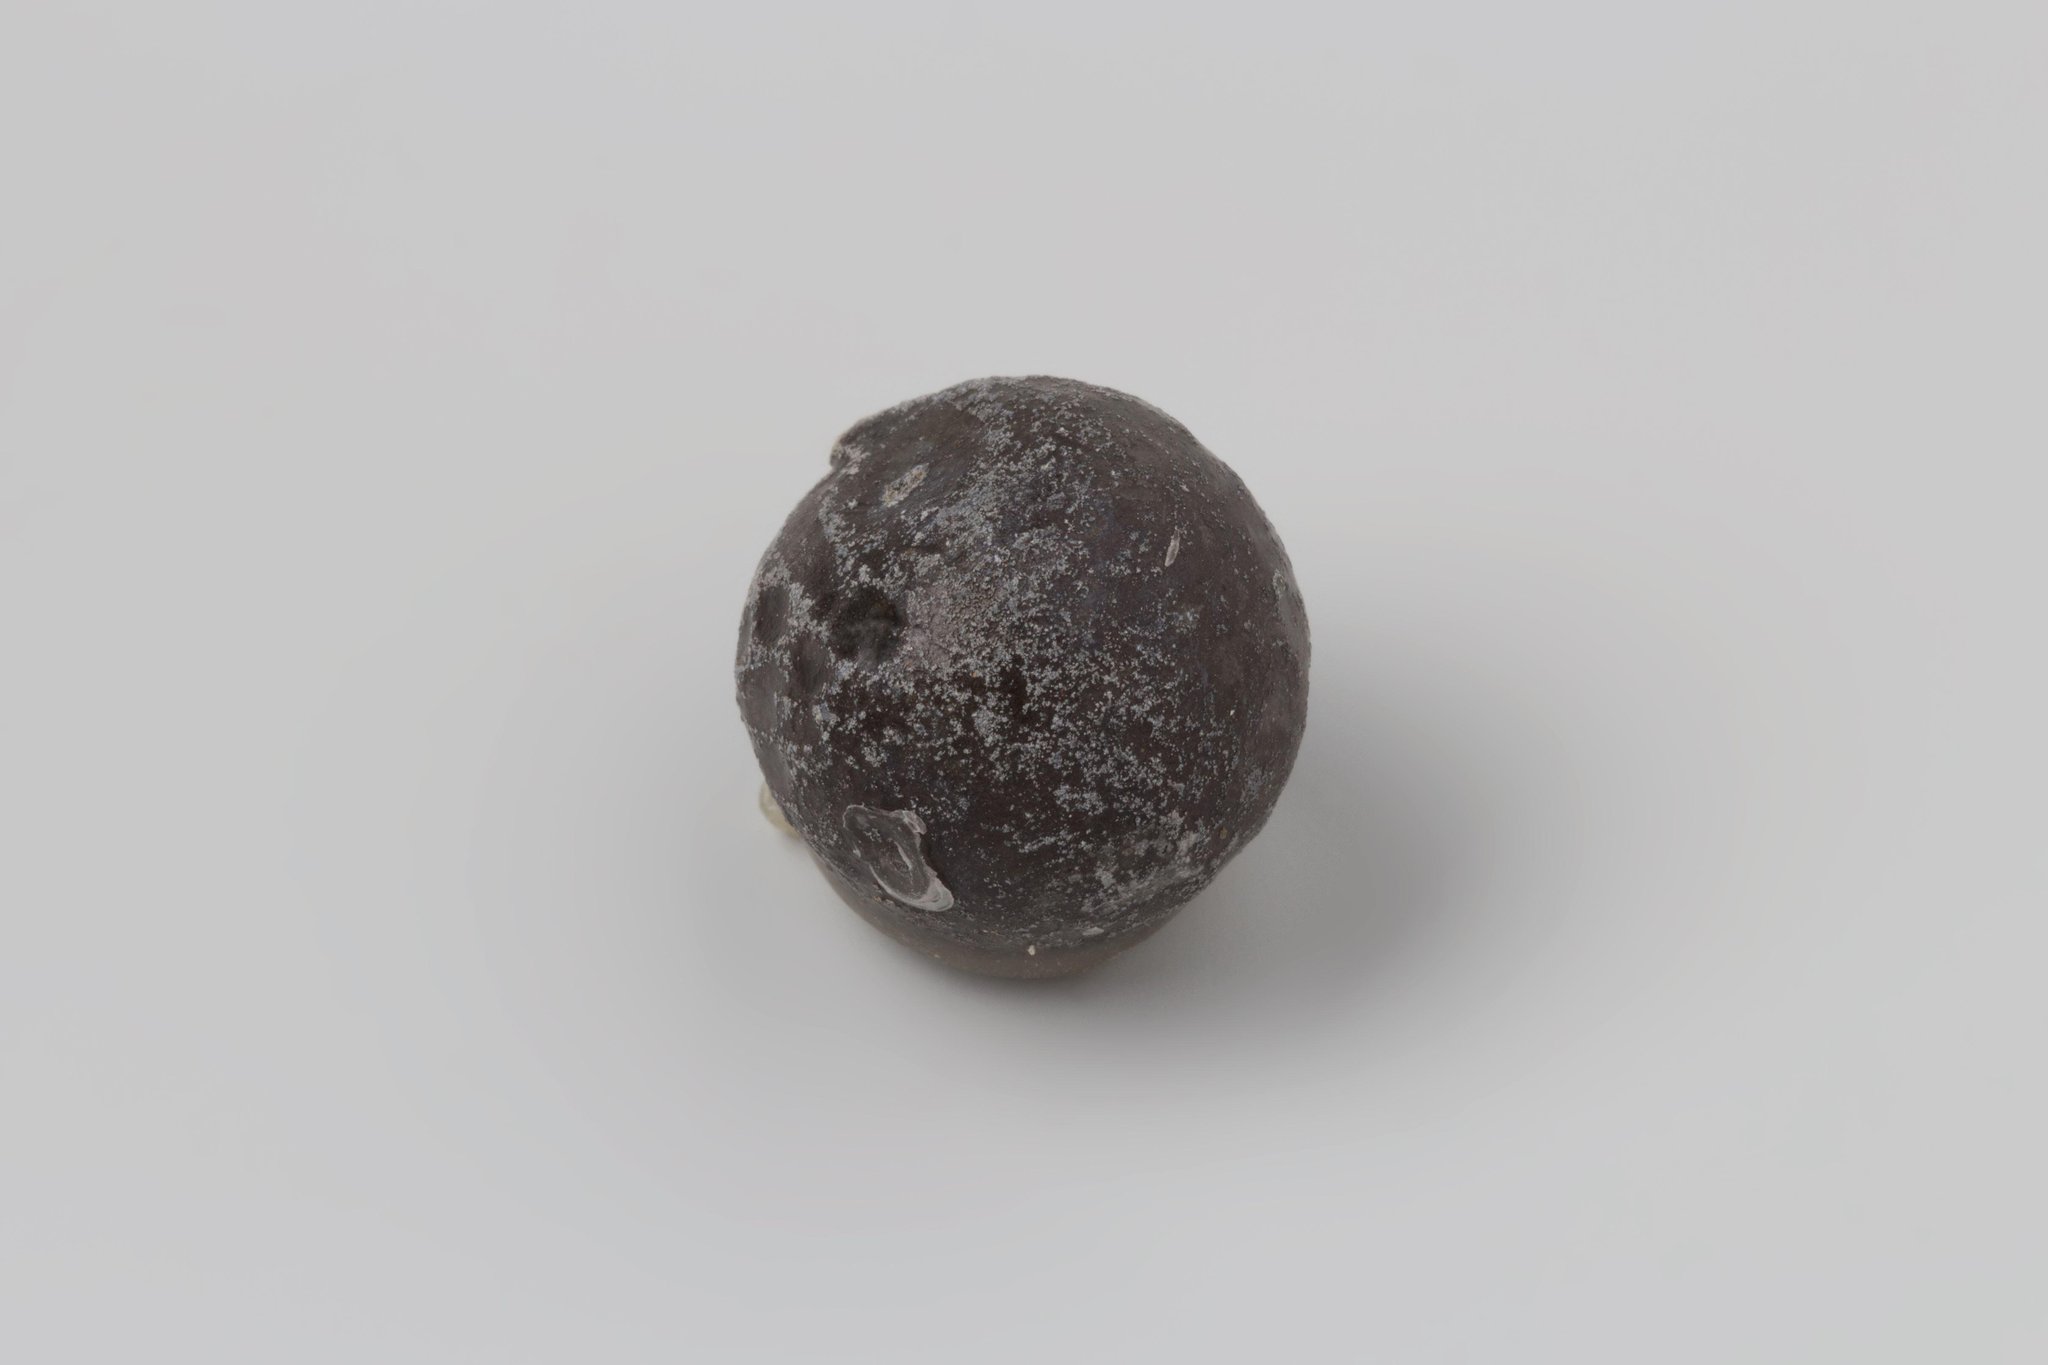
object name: musketkogel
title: Musketkogel uit het wrak van de Oost-Indiëvaarder 't Vliegend Hart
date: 1700-1735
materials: lead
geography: middelburg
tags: 't vliegend hart (schip), verenigde oostindische compagnie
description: Loden bolvormige kogel die uit een musket werd afgevuurd. De kogel is donkergrijs van kleur. De kogel is ter conservatie in bijenwas gedompeld. Identiek aan NG-1984-1 t/m 4. Musket calibre.